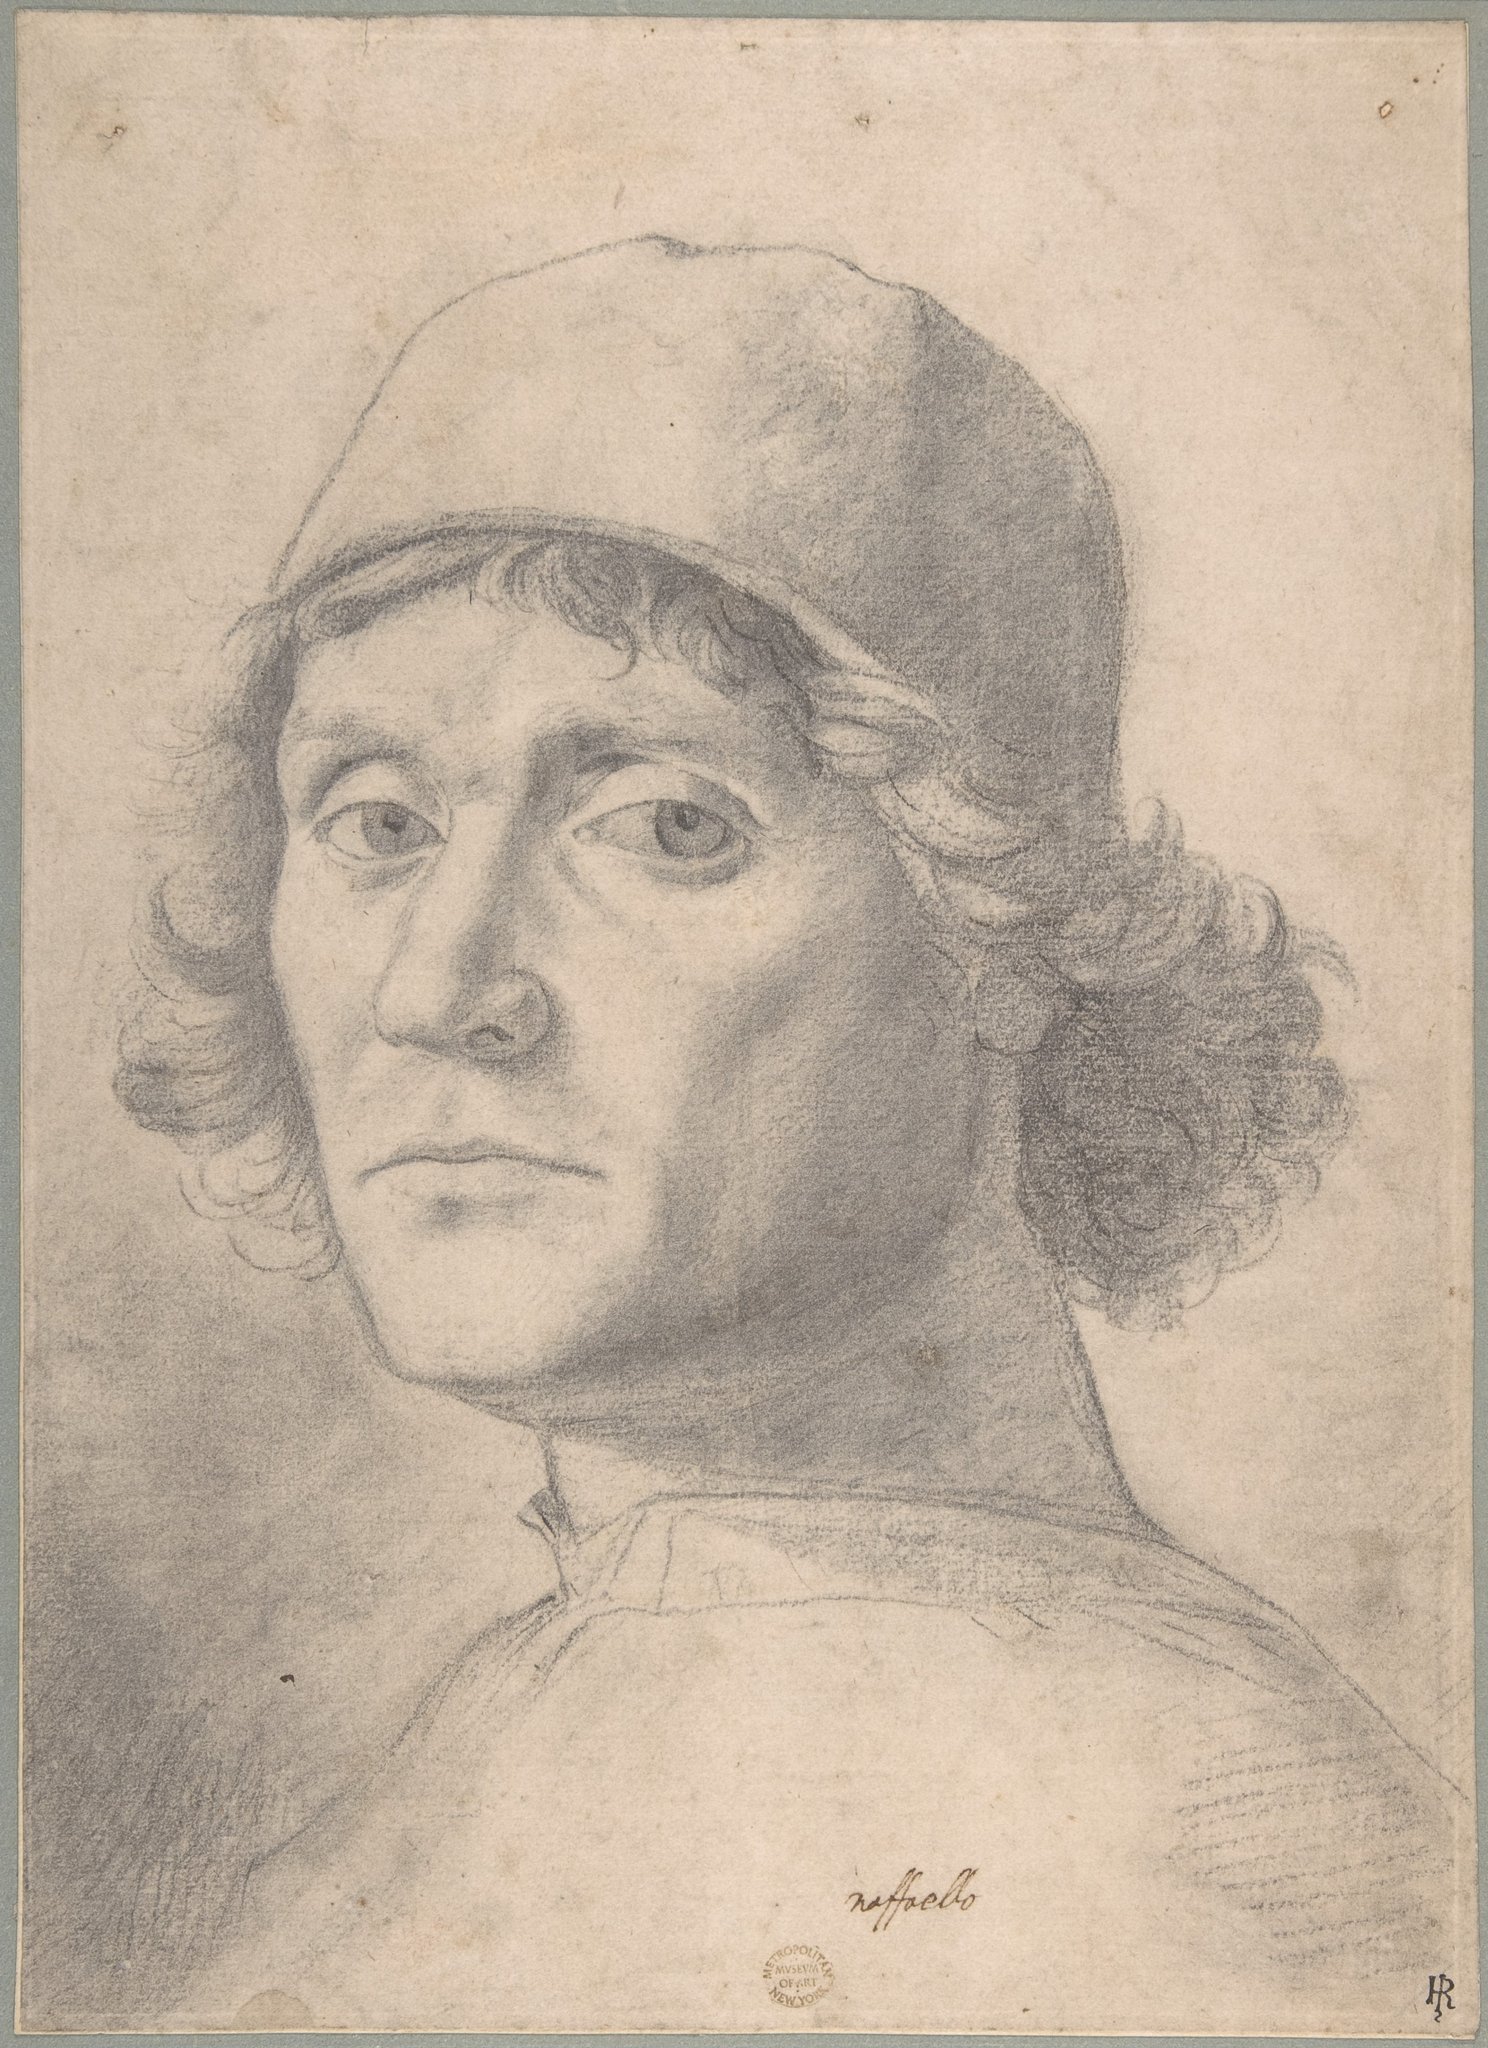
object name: drawing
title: Bust of a Man, His Gaze Directed Toward the Spectator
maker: anonymous, italian, 16th century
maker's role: artist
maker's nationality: italian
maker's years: 1500-1600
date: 1500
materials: chalk, charcoal, ink, paper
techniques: pen, stumping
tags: men,portraits